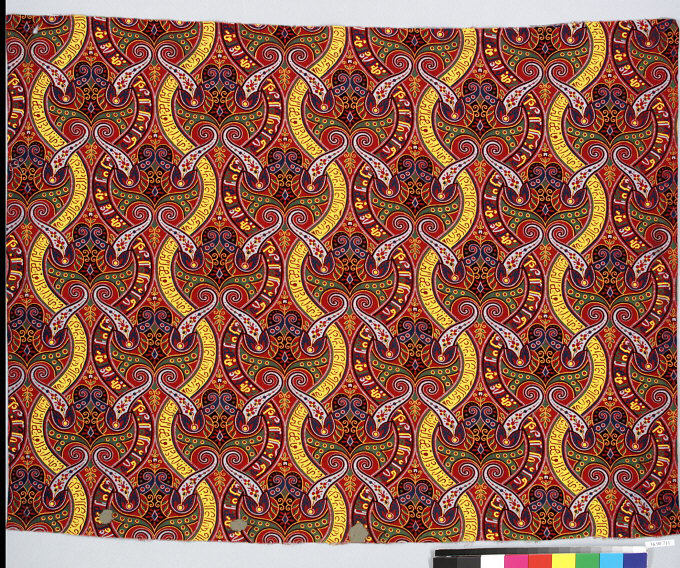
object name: piece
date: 1867-1900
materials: cotton